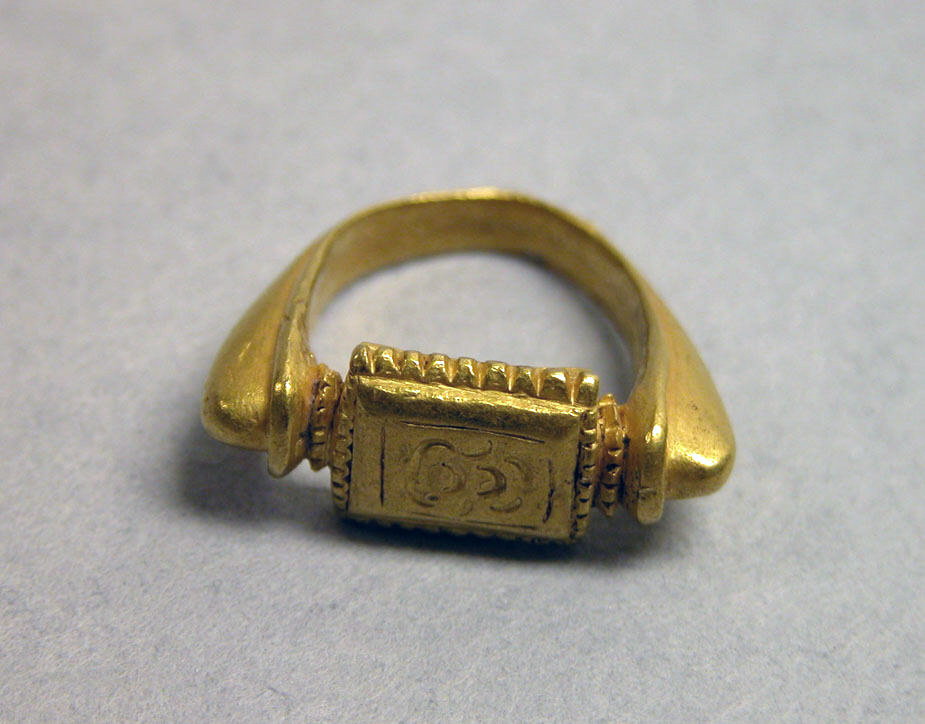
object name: ring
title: Stirrup-shaped Ring with Rectangular Bezel with "Sri"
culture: indonesian, javanese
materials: gold